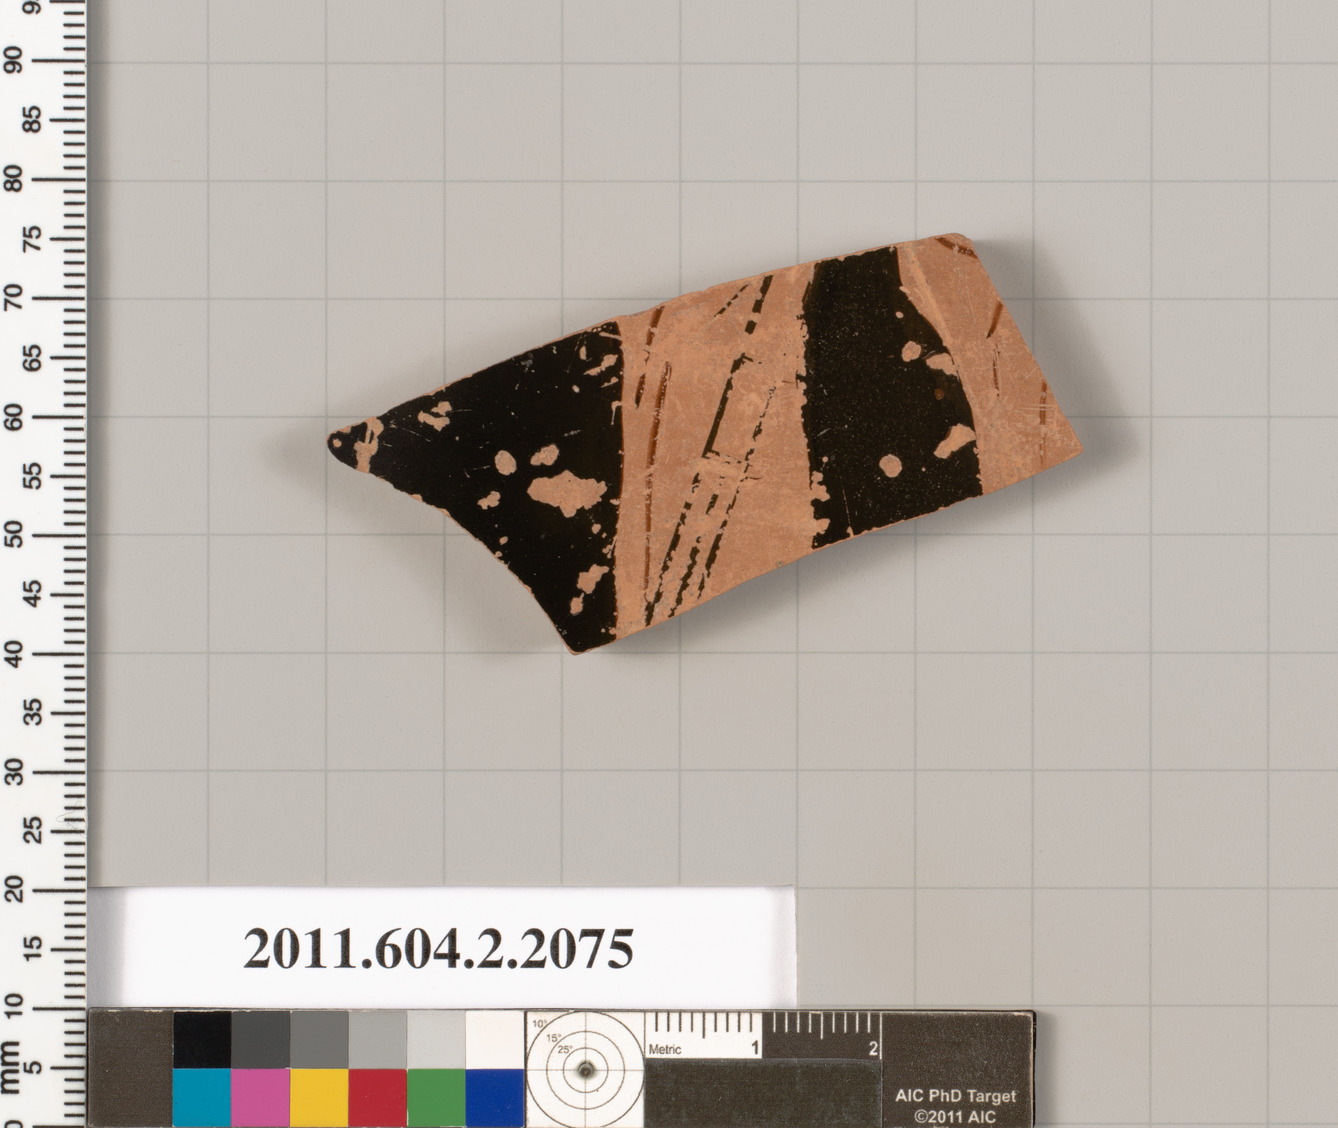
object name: pot fragment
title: Terracotta fragment of a pot; glazed on the inside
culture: greek, attic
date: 460-440 BCE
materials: terracotta